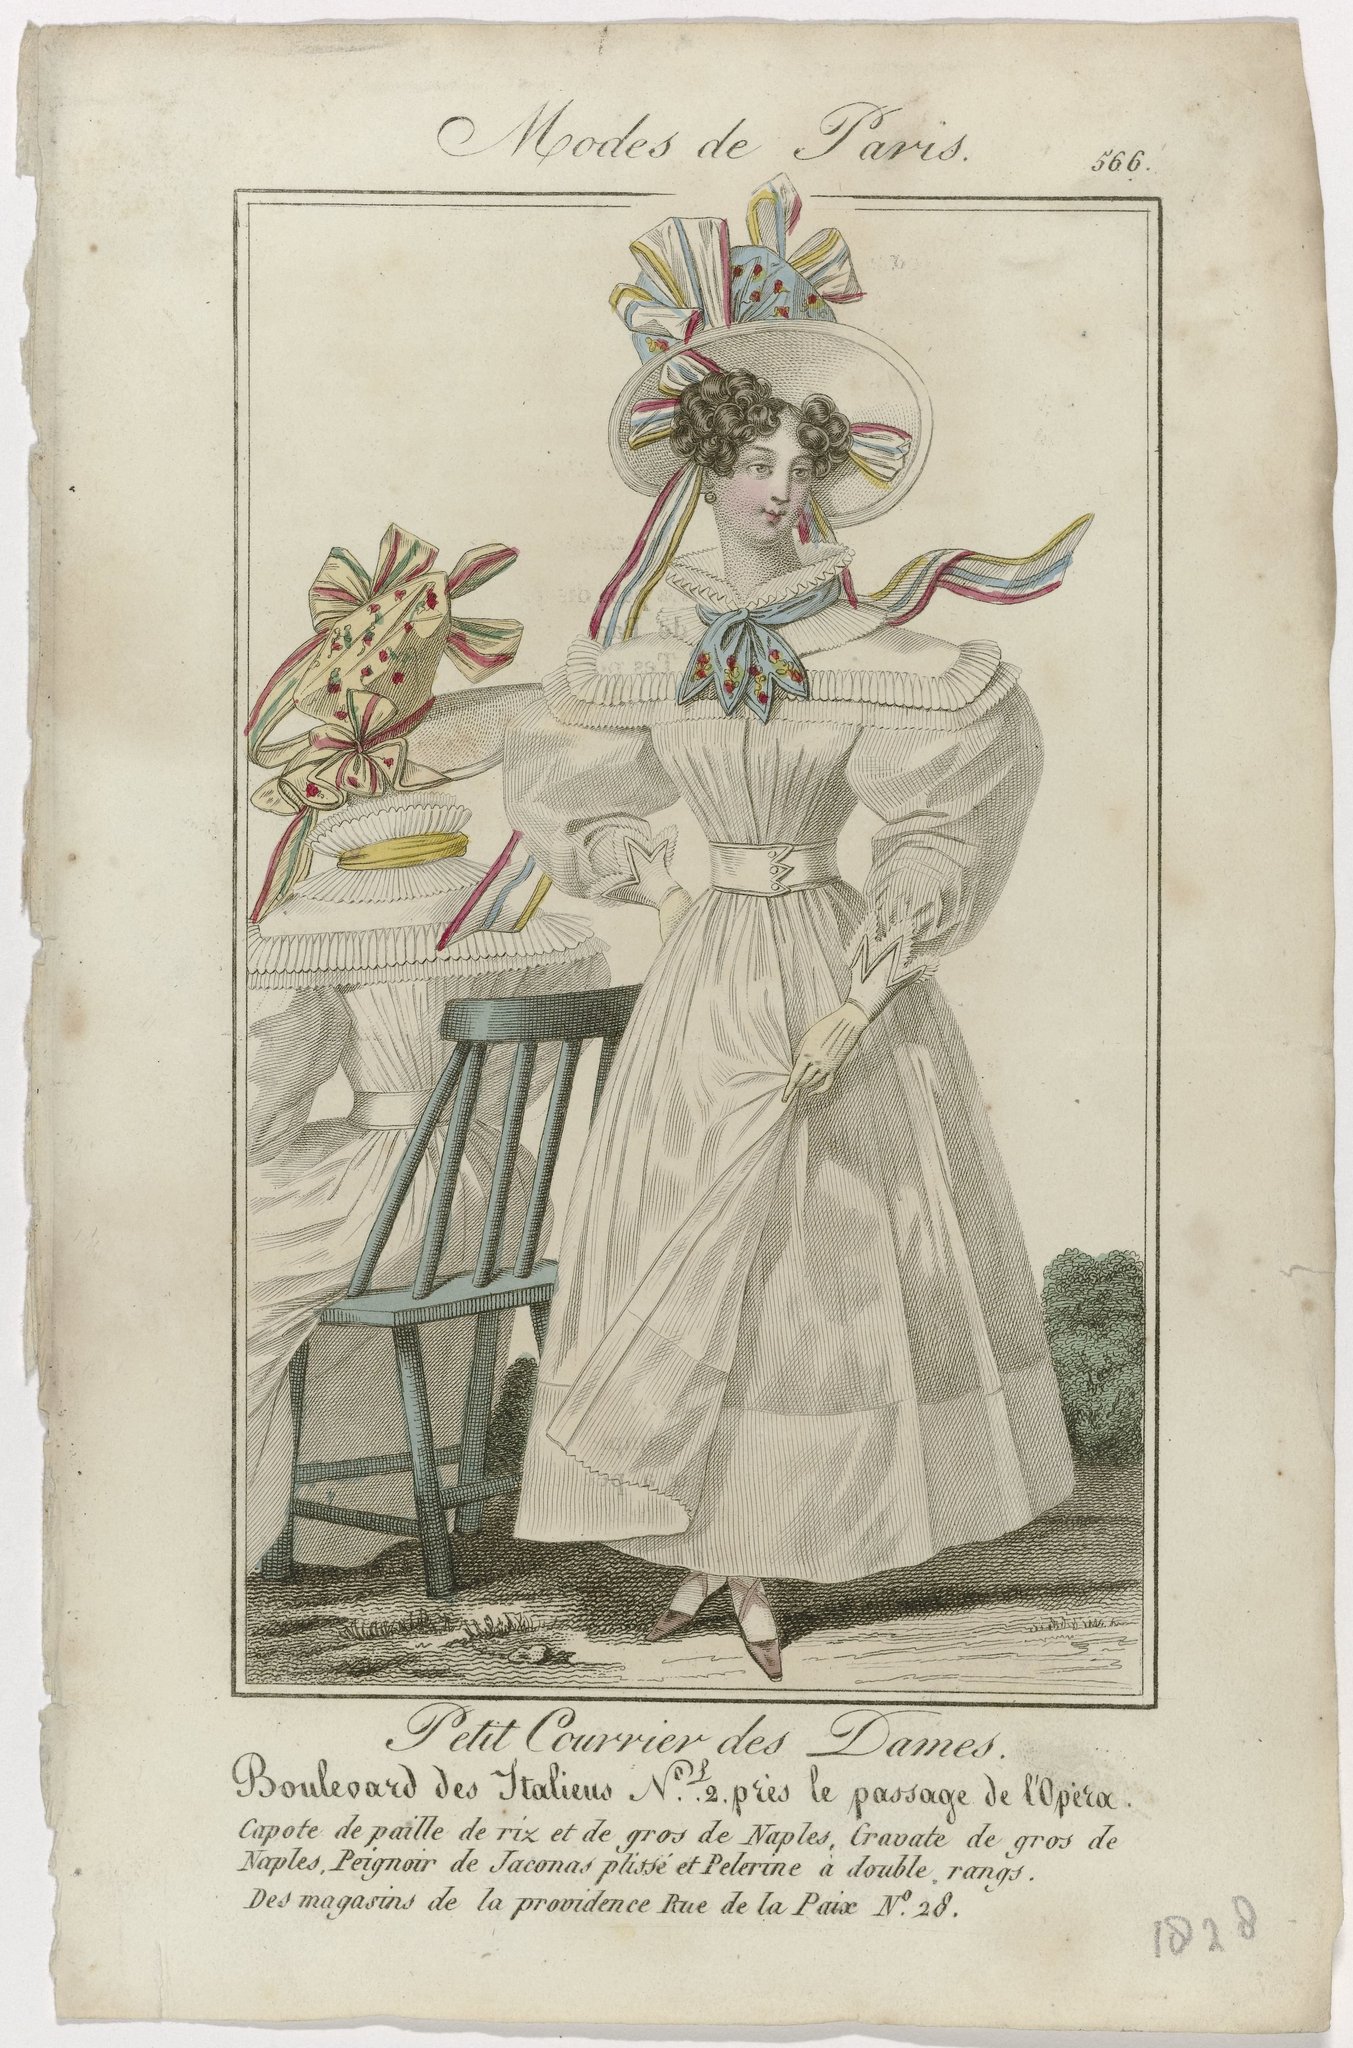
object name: fashion print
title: Petit Courrier des Dames, 1828, No. 566 : Capote de paille de riz (...)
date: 1828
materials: paper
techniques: engraving, hand coloring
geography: paris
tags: ear-rings (+ women's clothes), head-gear (capote) (+ women's clothes), clothing for the upper part of the body (pelerine) (+ women's clothes), neck-gear ~ clothing (cravat) (+ women's clothes), coat (housecoat) (+ women's clothes), fashion plates, shoes, sandals (+ women's clothes), gloves, mittens, etc. (+ women's clothes), belt, girdle, waistband (+ women's clothes)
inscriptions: address: ‘Boulevard des Italiens No.2 près le passage de l'Opèra.’, title: ‘Petit Courrier des Dames.’, caption: ‘Capote de paille de riz et de gros de Naples, Cravate de gros de Naples, Peignoir de Jaconas plissé et pelerine à double rangs, Des magasins de la providence Rue de la Paix No. 28.’, title: ‘Modes de Paris.’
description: Capote van 'paille de riz' en 'gros de Naples'. Geknoopte halsdoek of cravate van 'gros de Naples'. 'Peignoir' van geplooide 'jaconas' en een pelerine afgezet met twee gerimpelde stroken. Verdere accessoires: oorbel in het rechteroor, handschoenen, schoenen met gekruiste banden. Prent uit het modetijdschrift Petit Courrier des Dames (1821-1868).